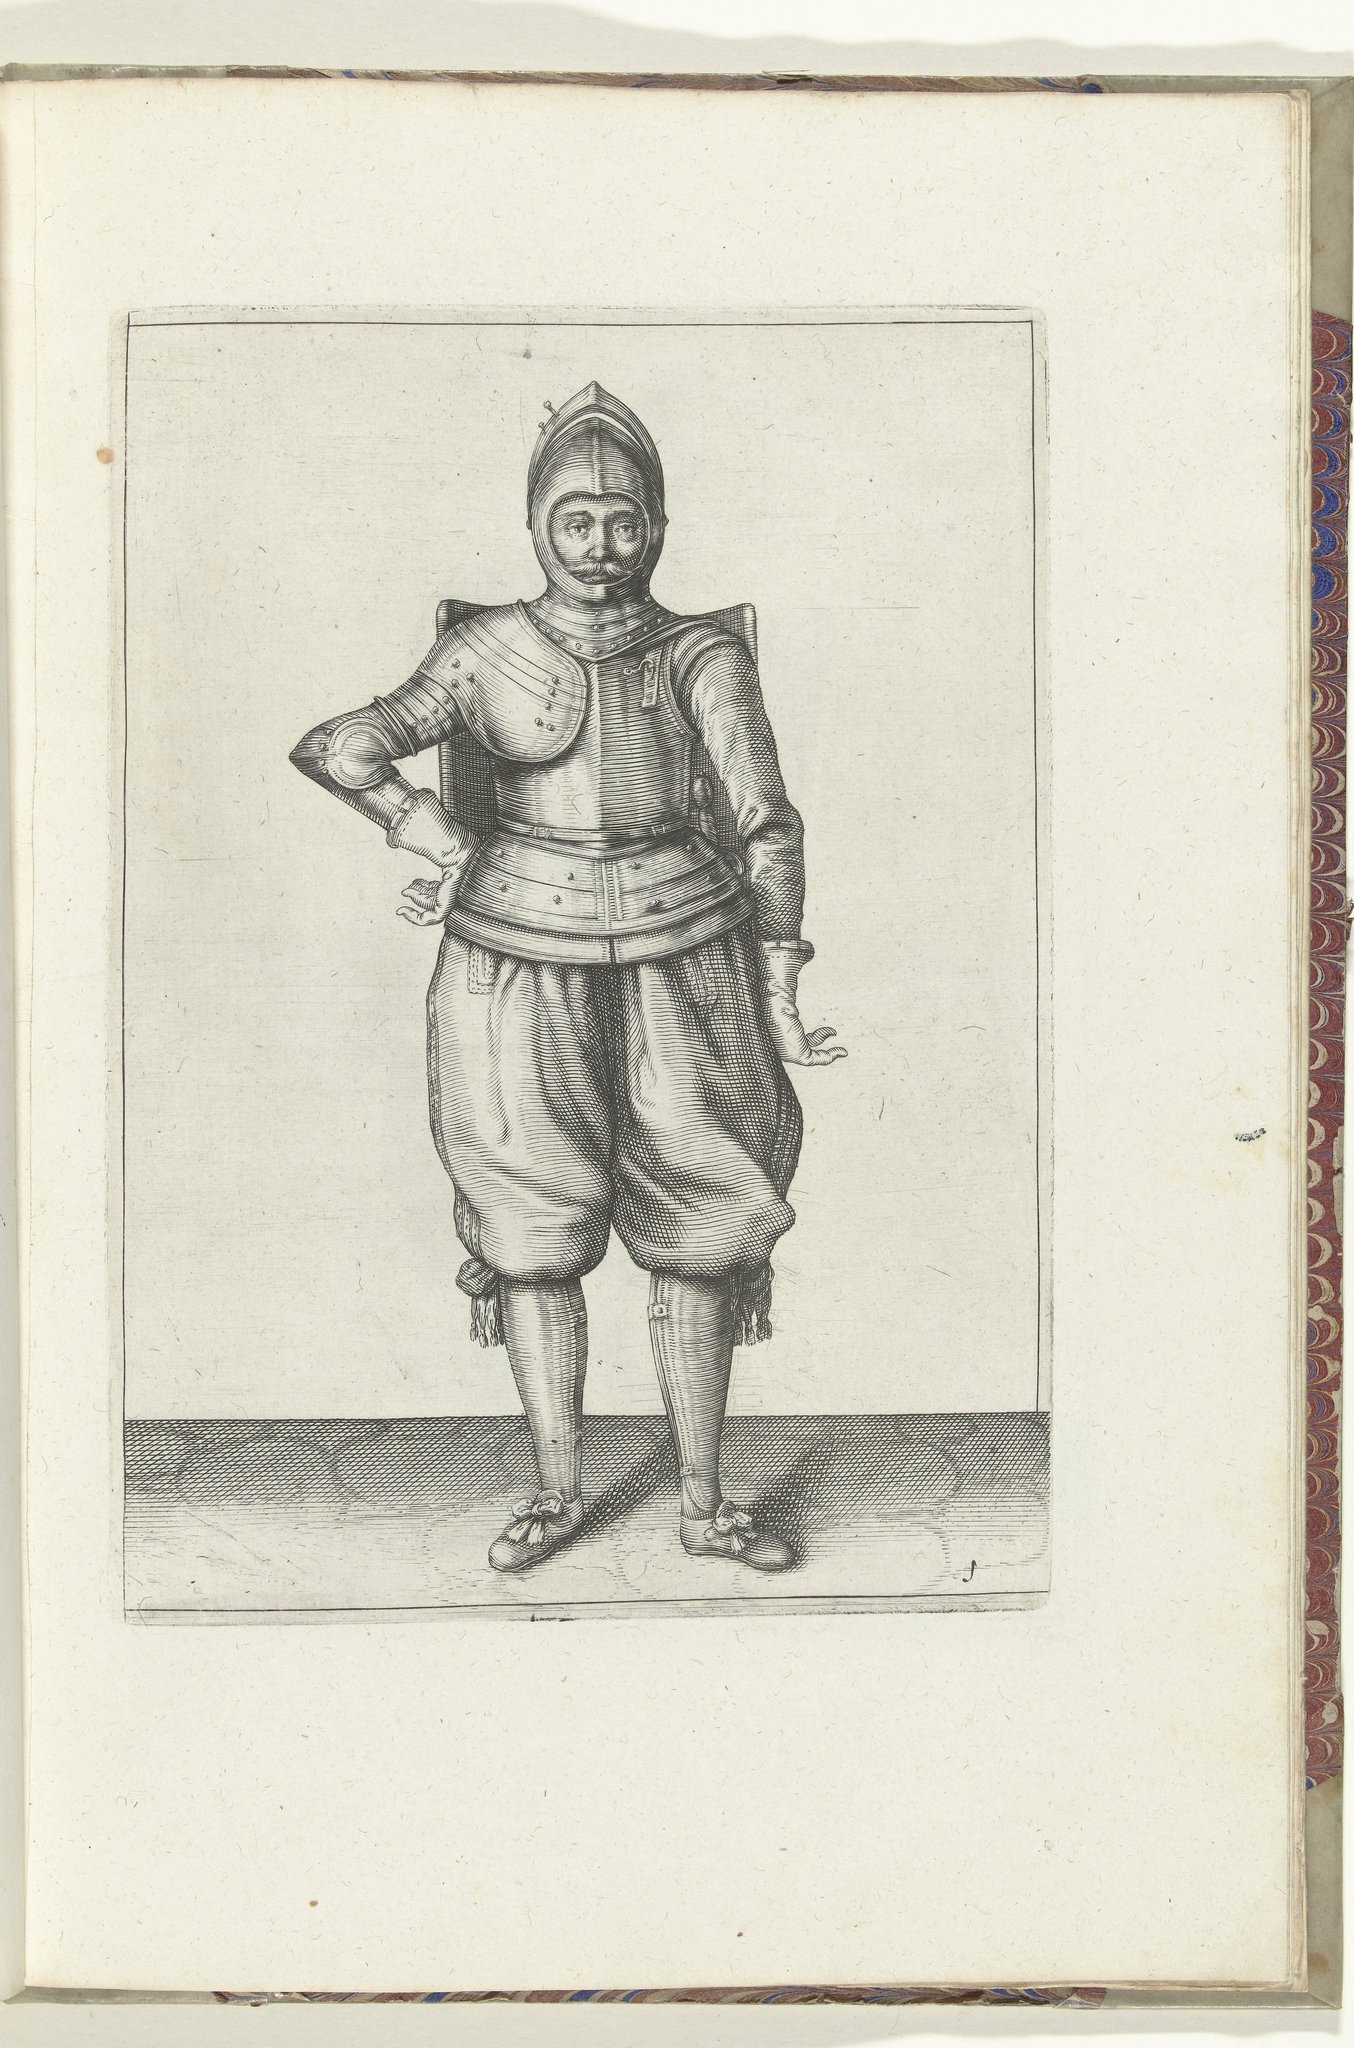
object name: print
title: De Nassausche Wapen-Handelinge, van Schilt, Spies, Rappier ende Targe : beyde figuerlick afgebeelt, ende gestelt na de nieu ordening [van] (...) Maurits van Nassau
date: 1616-1618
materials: paper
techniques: engraving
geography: northern netherlands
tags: maurice (prince of orange), handling of weapons ~ military training, weapons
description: Illustratie in: Adam van Breen, De Nassausche Wapen-Handelinge, van Schilt, Spies, Rappier ende Targe : beyde figuerlick afgebeelt, ende gestelt na de nieu ordening [van] ... Maurits van Nassau / Korte Onderwijsinge op de figuerlijcke af-beeldinghe belangende 'trecht ghebruyck van al 'tghene een Soldaet noodigh is in het handelen vande Targes met het Rappier, 's-Gravenhage, [Aert Meuris] 1618, plaat nr. 1. In het exemplaar in de collectie van de Rijksmuseum Research Library (326 F 22).